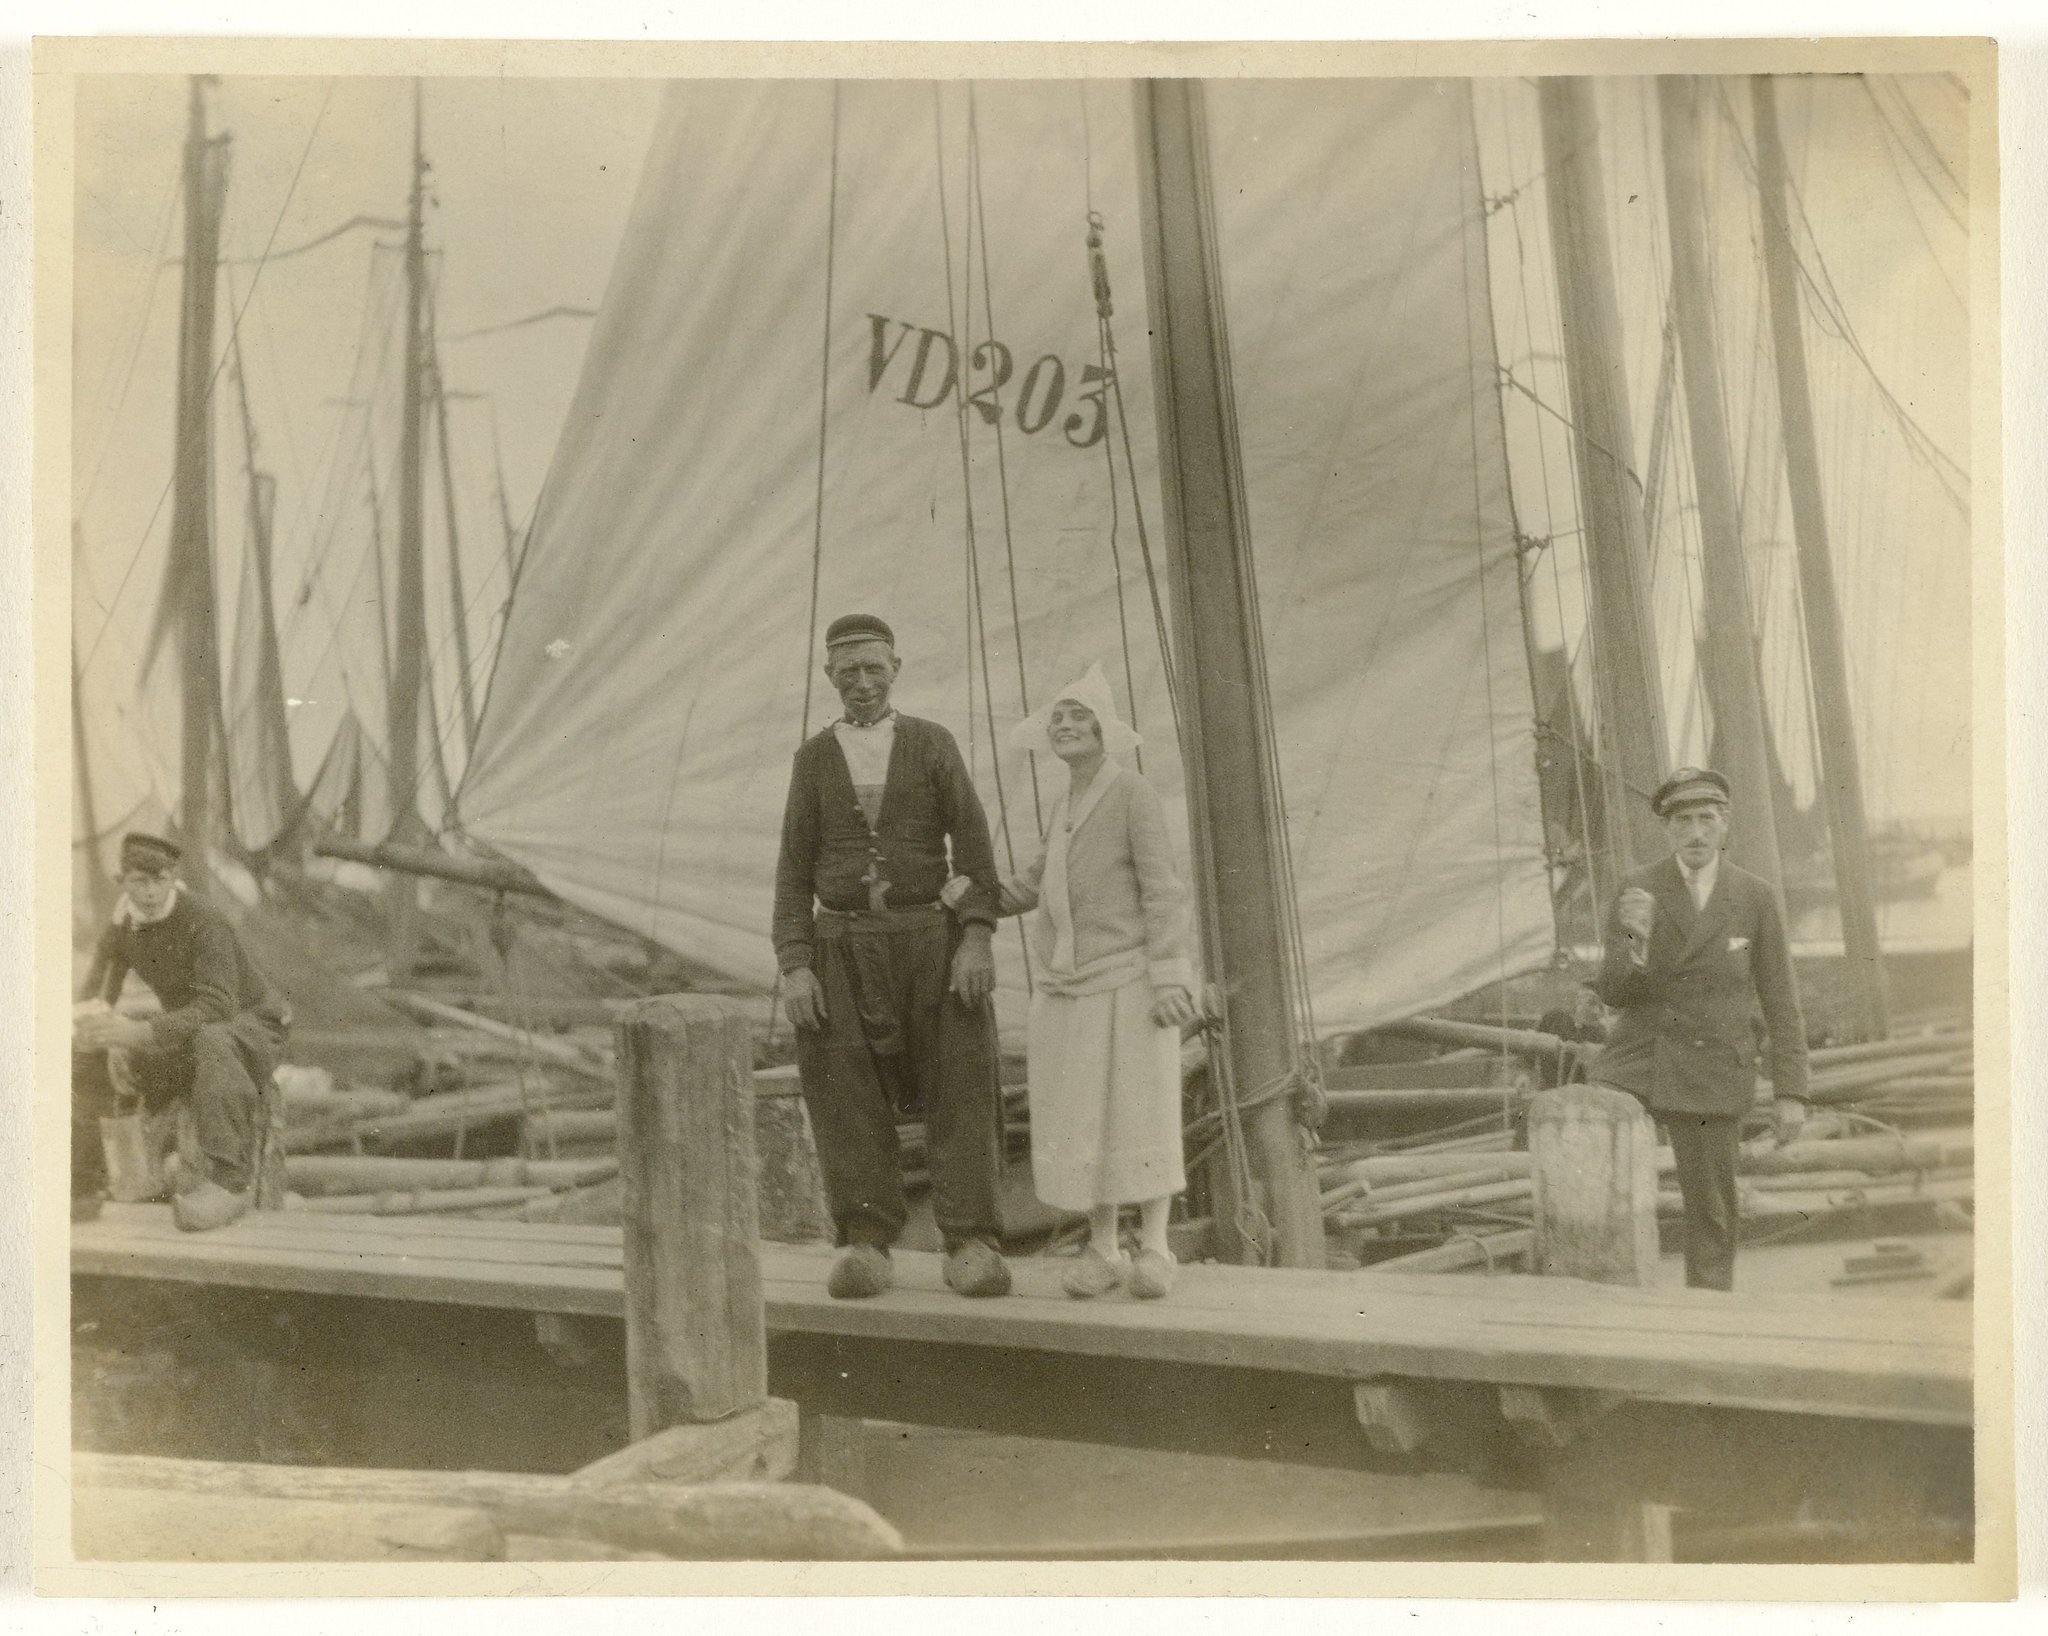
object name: photograph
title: Amerikaanse toeriste in Volendammer klederdracht in de haven van Volendam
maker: Anonymous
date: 1921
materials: paper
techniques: gelatin silver print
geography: volendam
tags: tourism